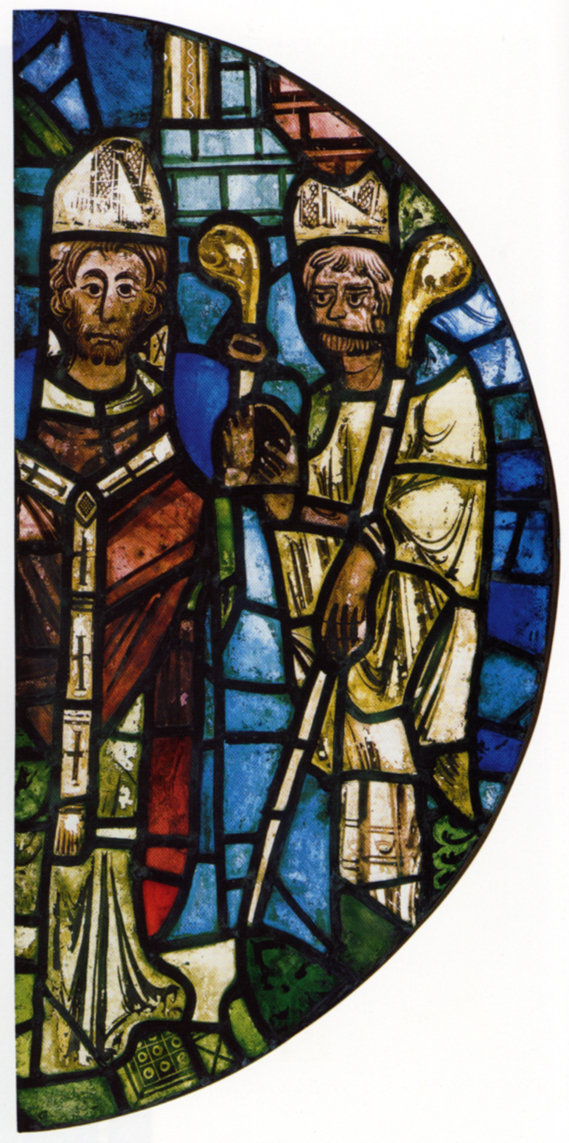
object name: panel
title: Saint Martial Founding the Cathedral of Saint-Pierre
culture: french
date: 1190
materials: glass, lead, metal, paint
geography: france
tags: men,saints